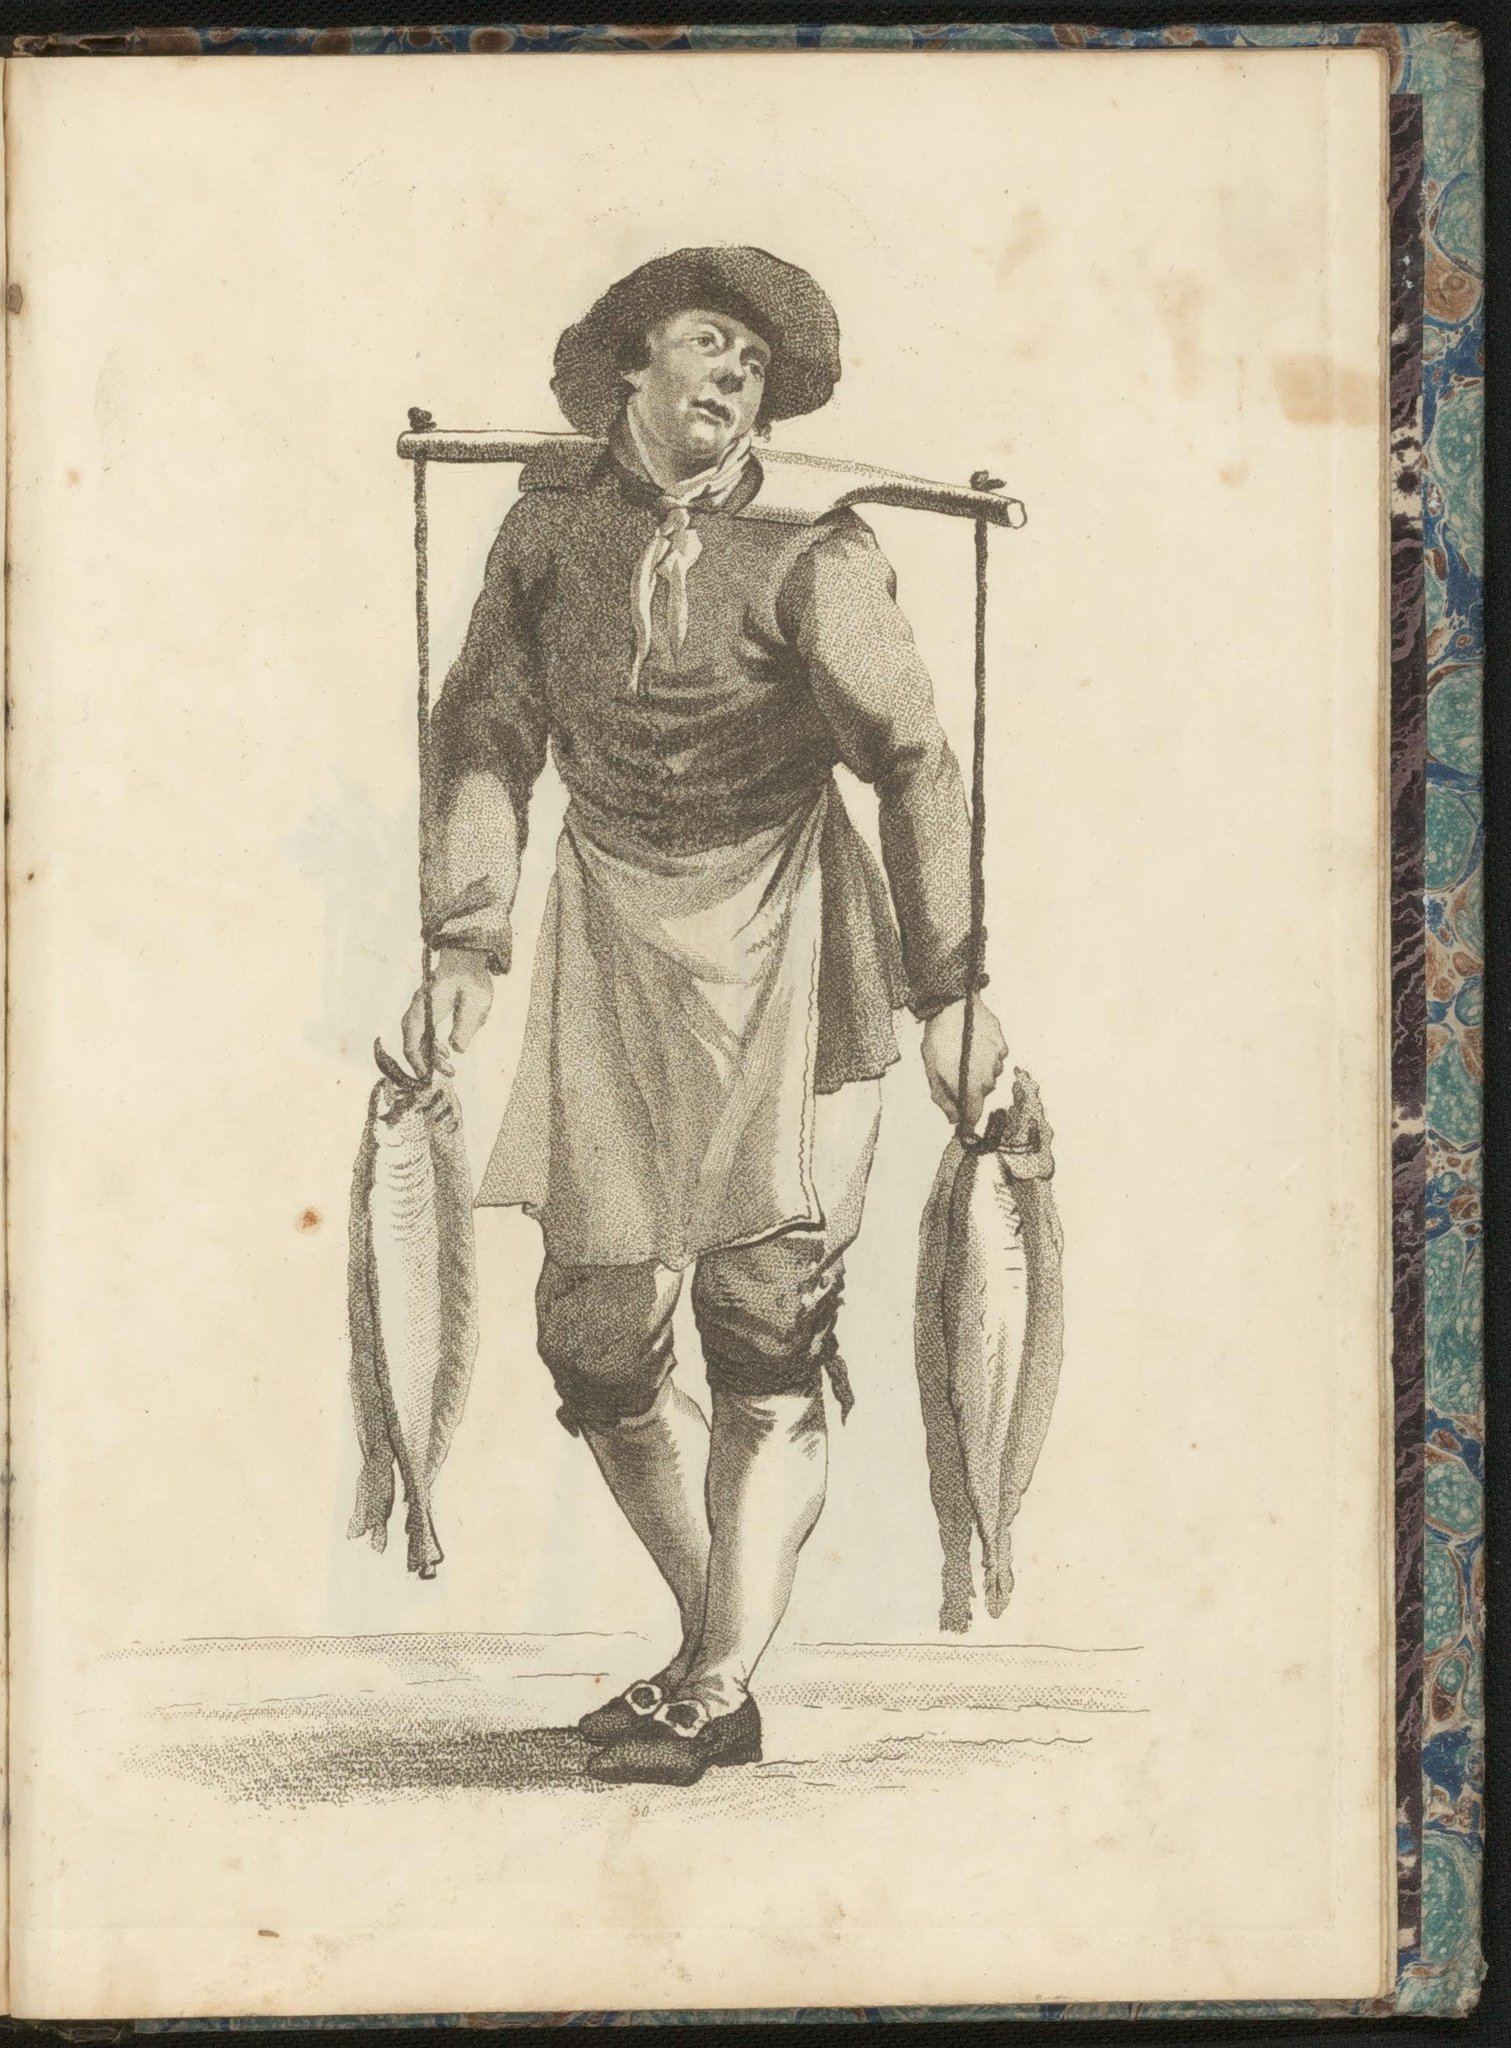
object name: print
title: Visverkoper draagt vissen aan een juk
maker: mathias de sallieth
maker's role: print maker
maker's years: 1749-1791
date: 1772-1791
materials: paper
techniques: printmaking, etching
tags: fishes, yoke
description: De prent verscheen vanaf 1818 tevens als onderdeel van een 33-delige reeks prenten door Mathias de Sallieth, samengebonden in: Perkois, Jacobus, Prins, Johannes Huibert. Verzameling van verschillende gekleede mans- en vrouwenstanden, ter oefening van jonge schilders en liefhebbers. Rotterdam: Johannes Immerzeel, 1818. Alle verso-bladen uit dit prentalbum zijn blanco.